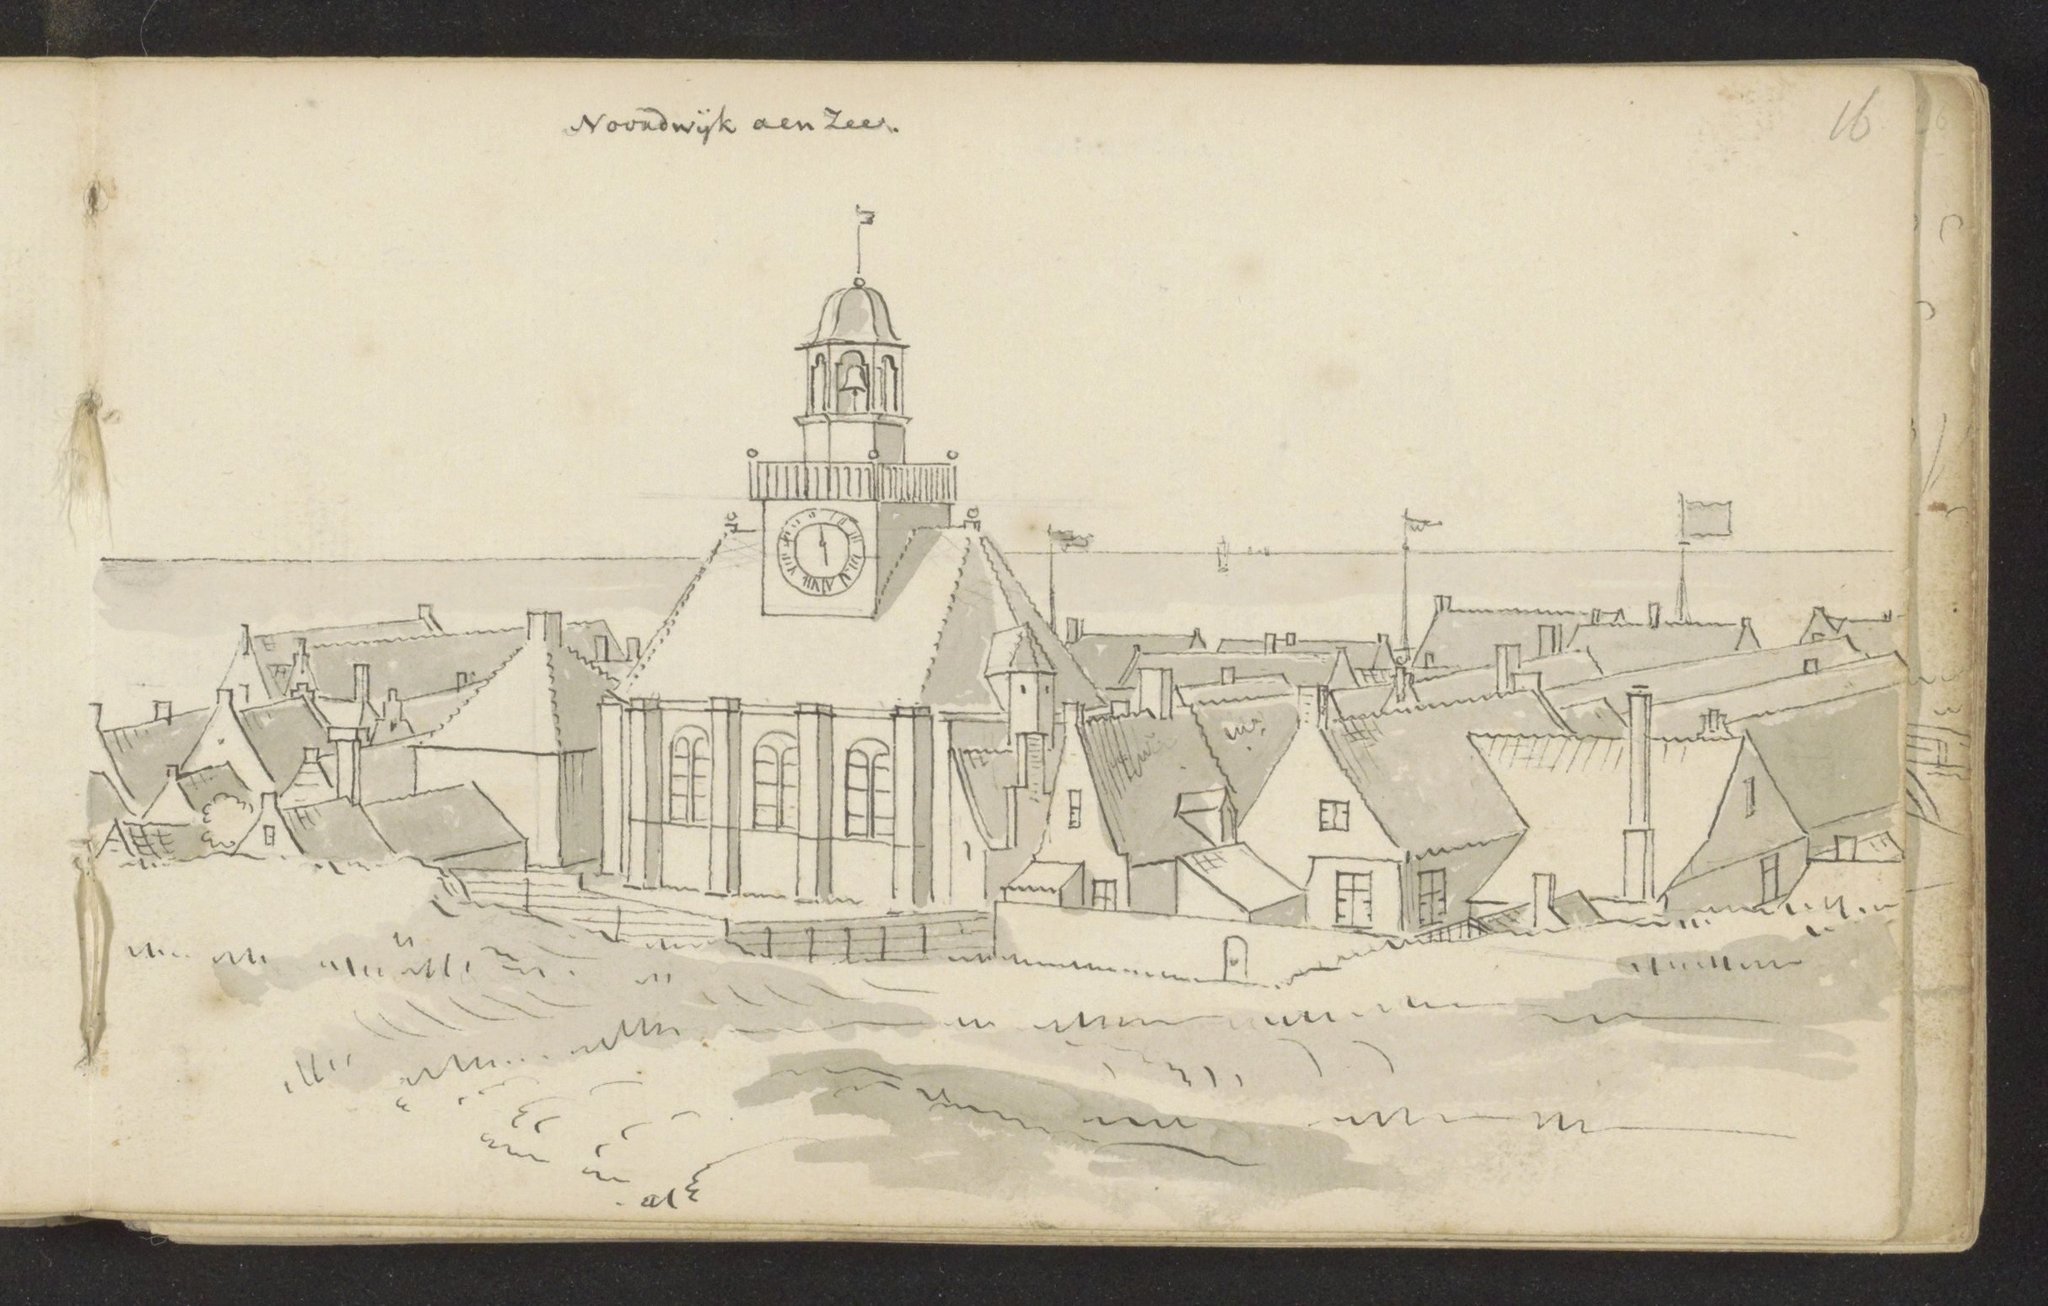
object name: sketchbook leaf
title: Gezicht op Noordwijk aan Zee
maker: abraham de haen (ii)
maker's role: draughtsman, print maker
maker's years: 1707-1748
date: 1731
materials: ink, paper, pencil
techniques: brush, pen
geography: noordwijk aan zee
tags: village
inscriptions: annotation: ‘Noordwijk aan Zee’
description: Blad 16 recto uit een schetsboek met 78 bladen.